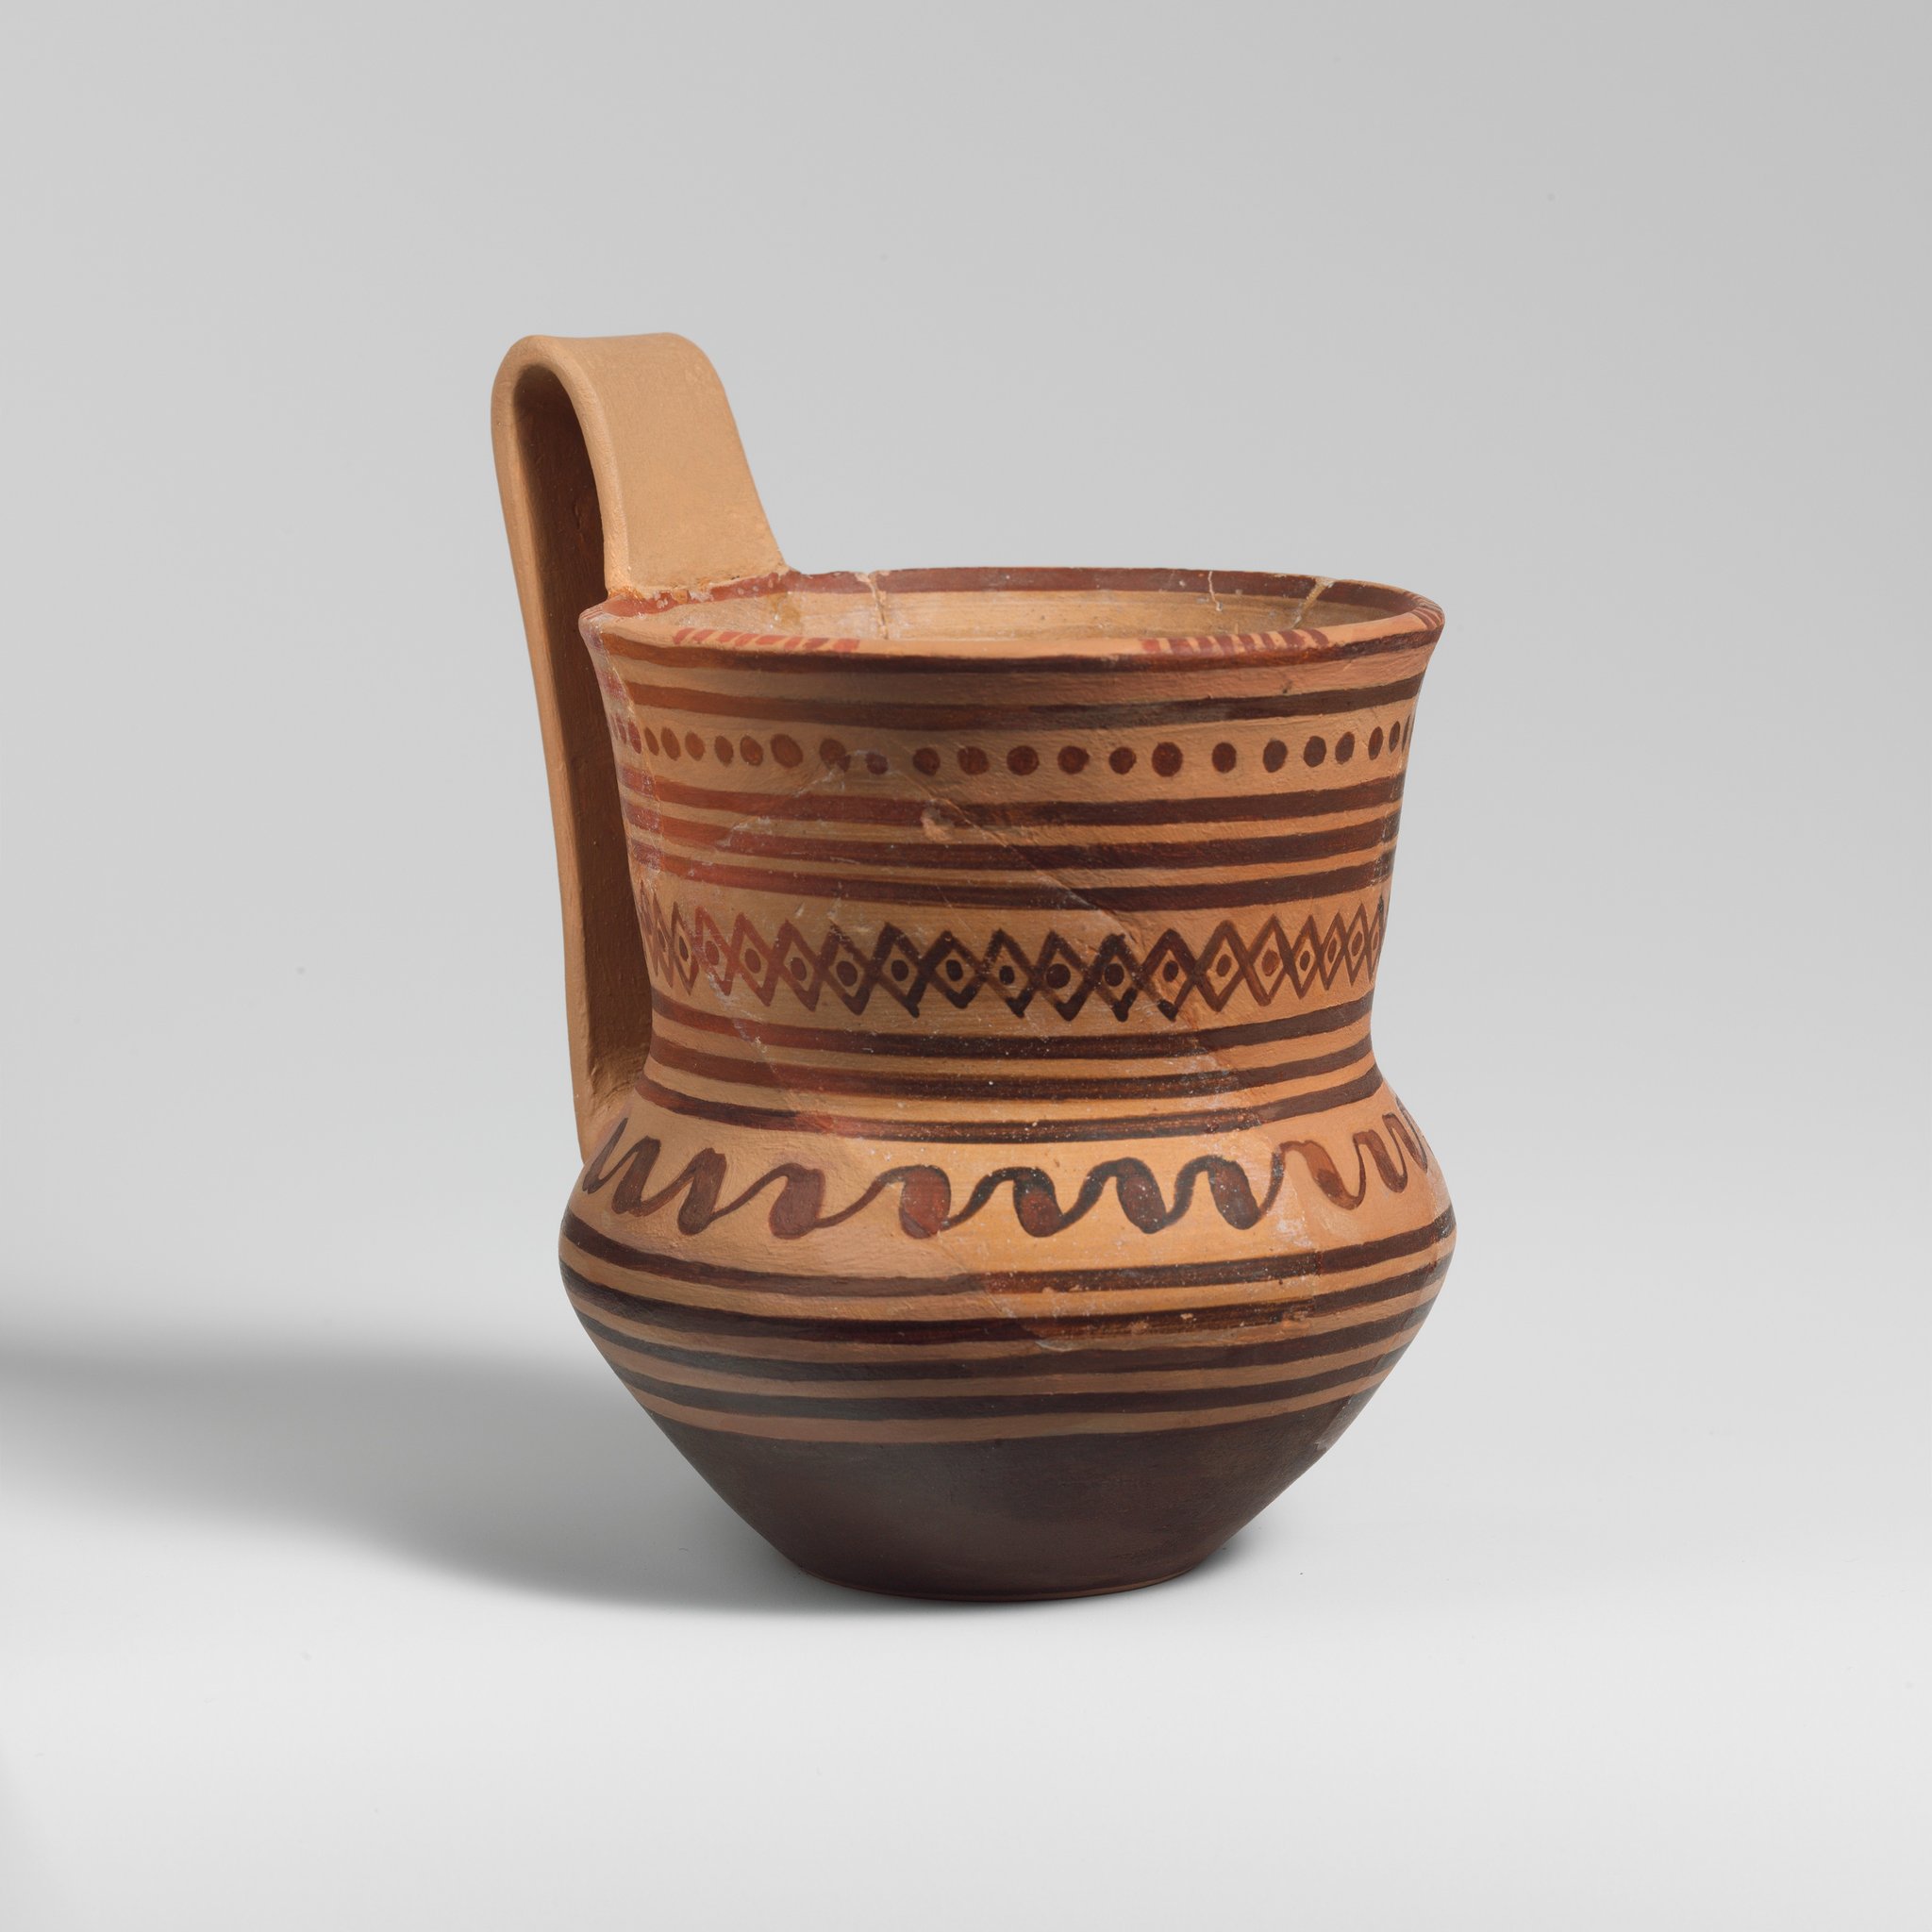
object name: tankard, fragmentary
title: Terracotta tankard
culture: greek, attic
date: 734-701 BCE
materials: terracotta